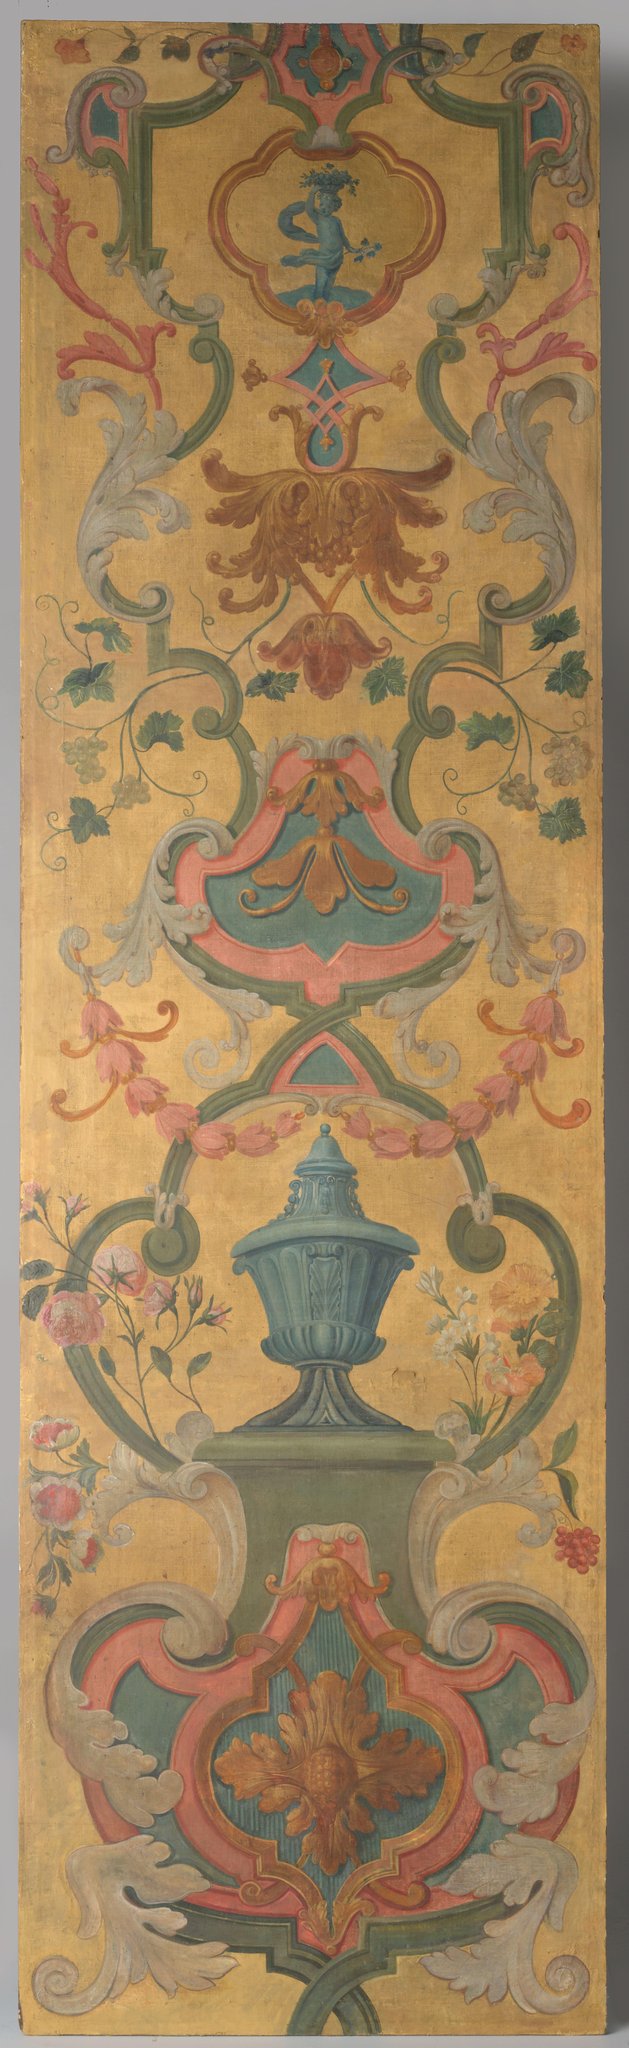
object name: vouwscherm, kamerscherm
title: Onderdeel van een kamerscherm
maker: Anonymous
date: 1700-1750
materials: linen, wood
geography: netherlands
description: Onderdeel van een kamerscherm van zes slagen, bespannen met beschilderd linnen waarop piedestals, vazen met bloemen, medaillons en vogels in diverse kleuren zijn aangebracht.